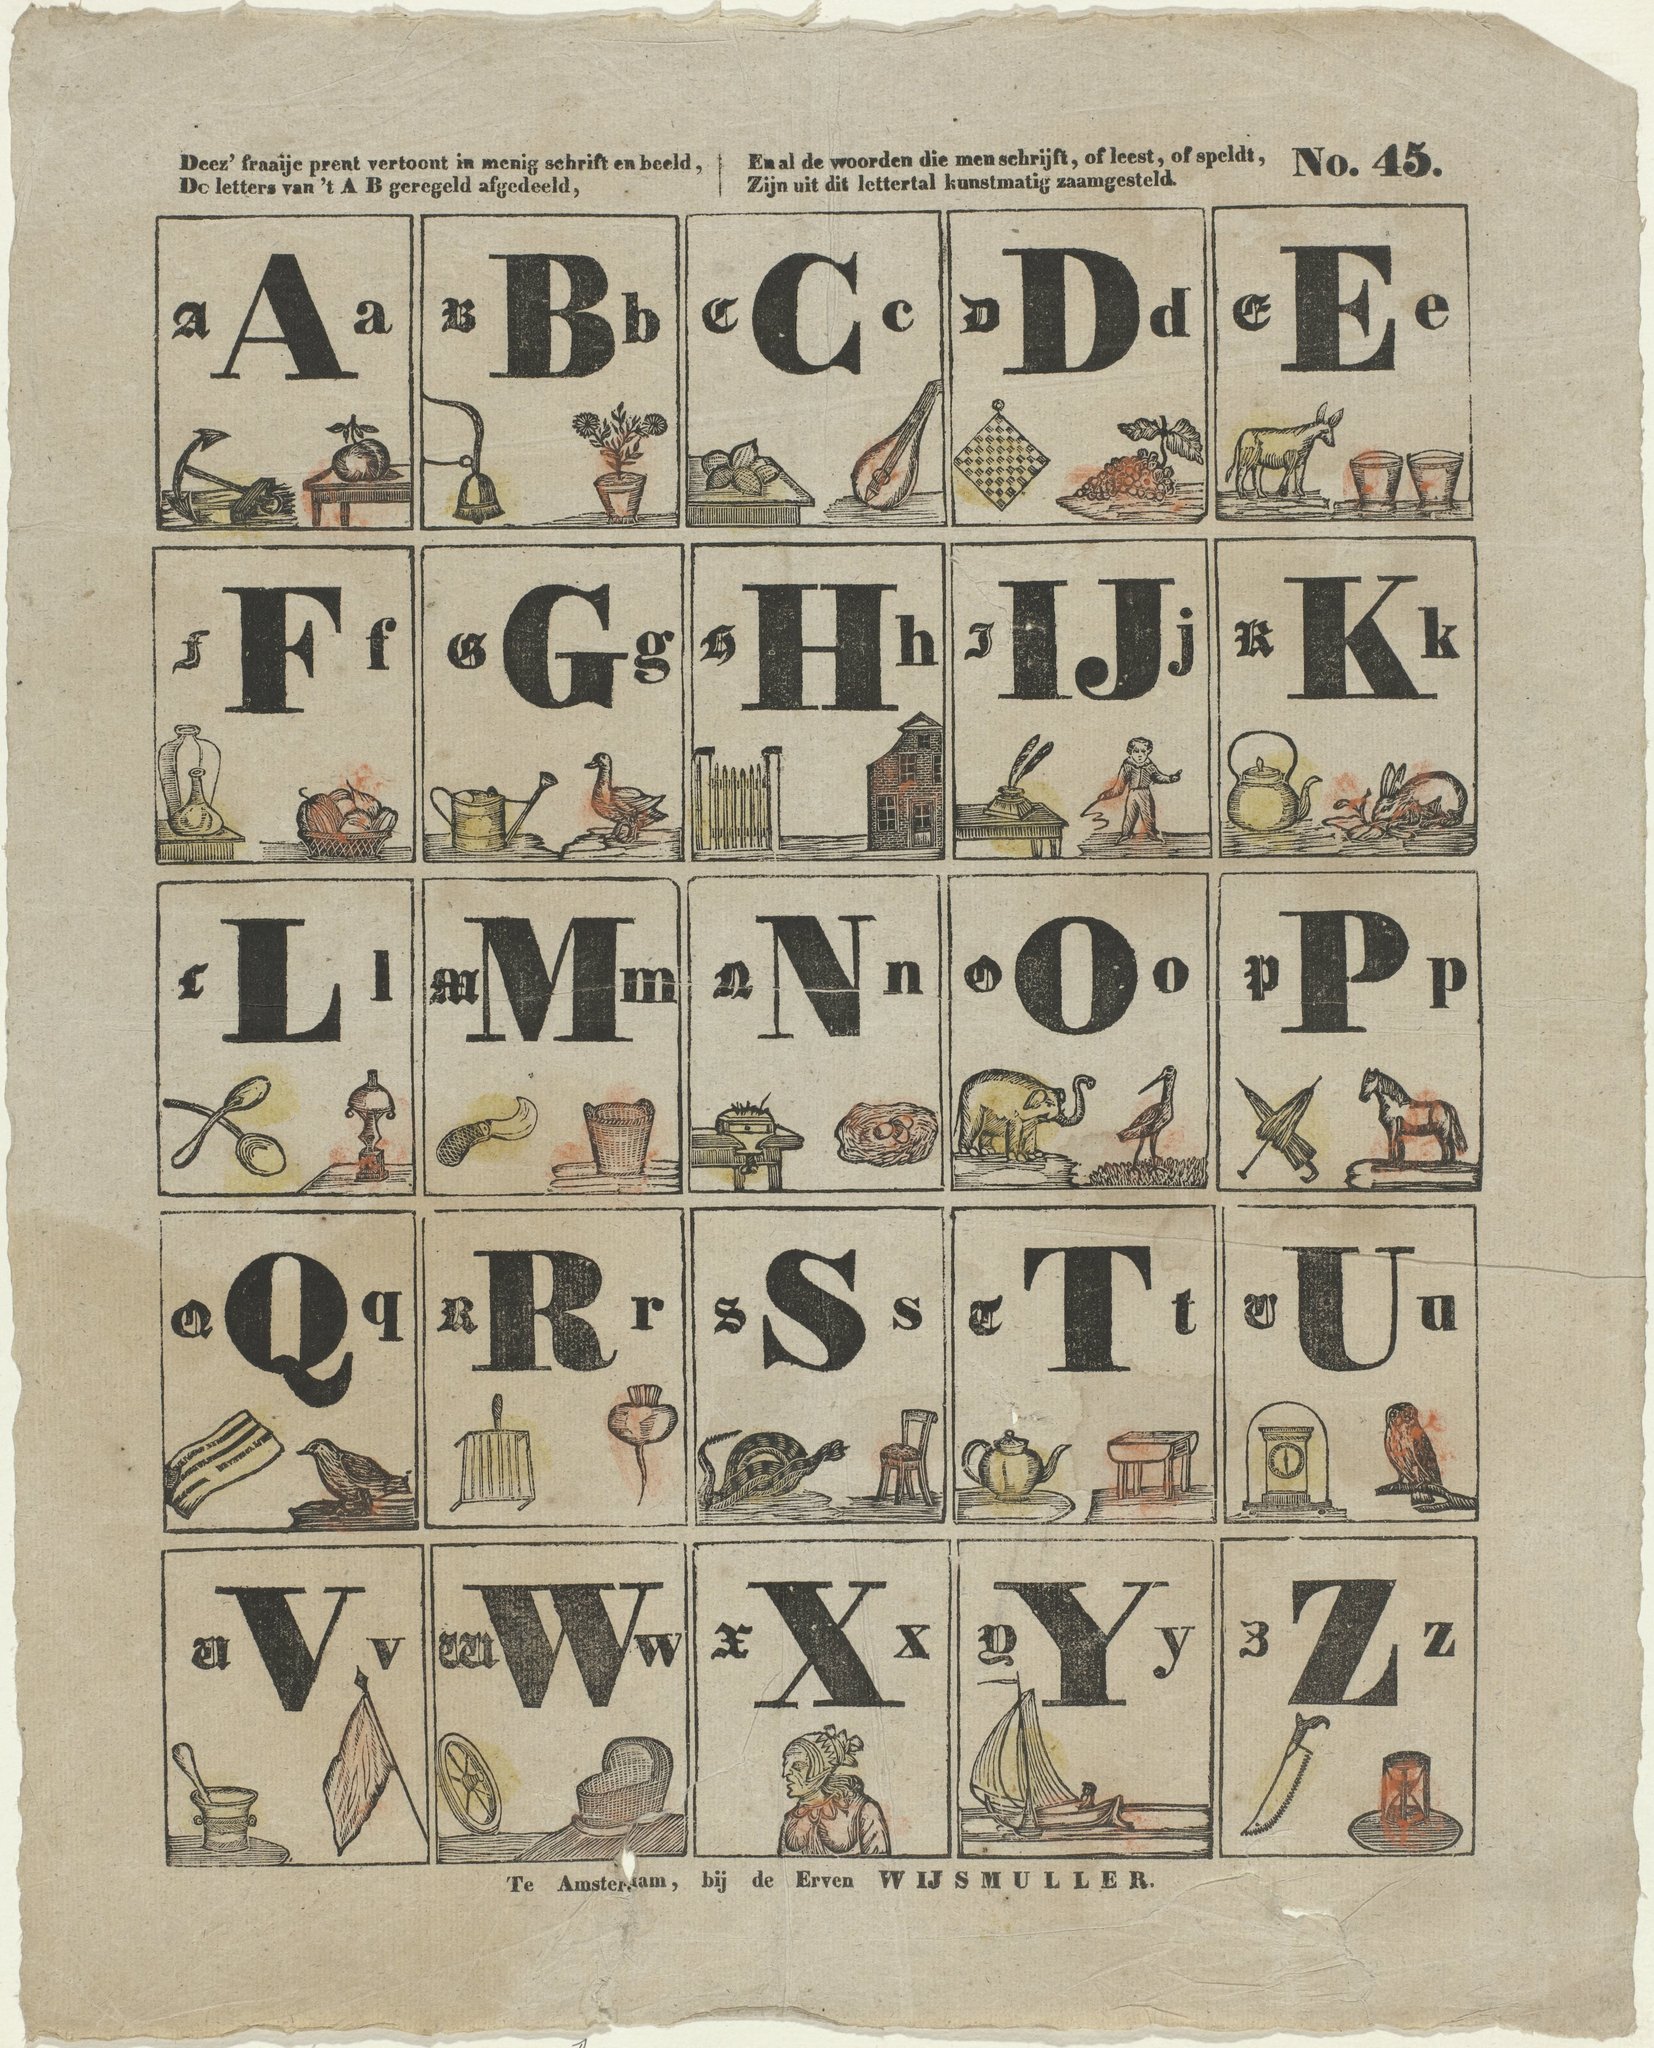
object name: print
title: Deez' fraaije prent vertoont in menig schrift en beeld, / De letters van 't A B geregeld afgedeeld, / En al de woorden die men schrijft, of leest, of speldt, / Zijn uit dit lettertal kunstmatig zaamgesteld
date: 1832-1850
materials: paper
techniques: colour, letterpress printing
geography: rotterdam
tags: letters, alphabet, script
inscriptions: collector's mark: Lugt 2760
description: Blad met 25 voorstellingen van de letters van het alfabet geïllustreerd met telkens twee voorwerpen, dieren of figuren waarvan de woorden met de betreffende letter beginnen. Genummerd rechtsboven: No. 45.